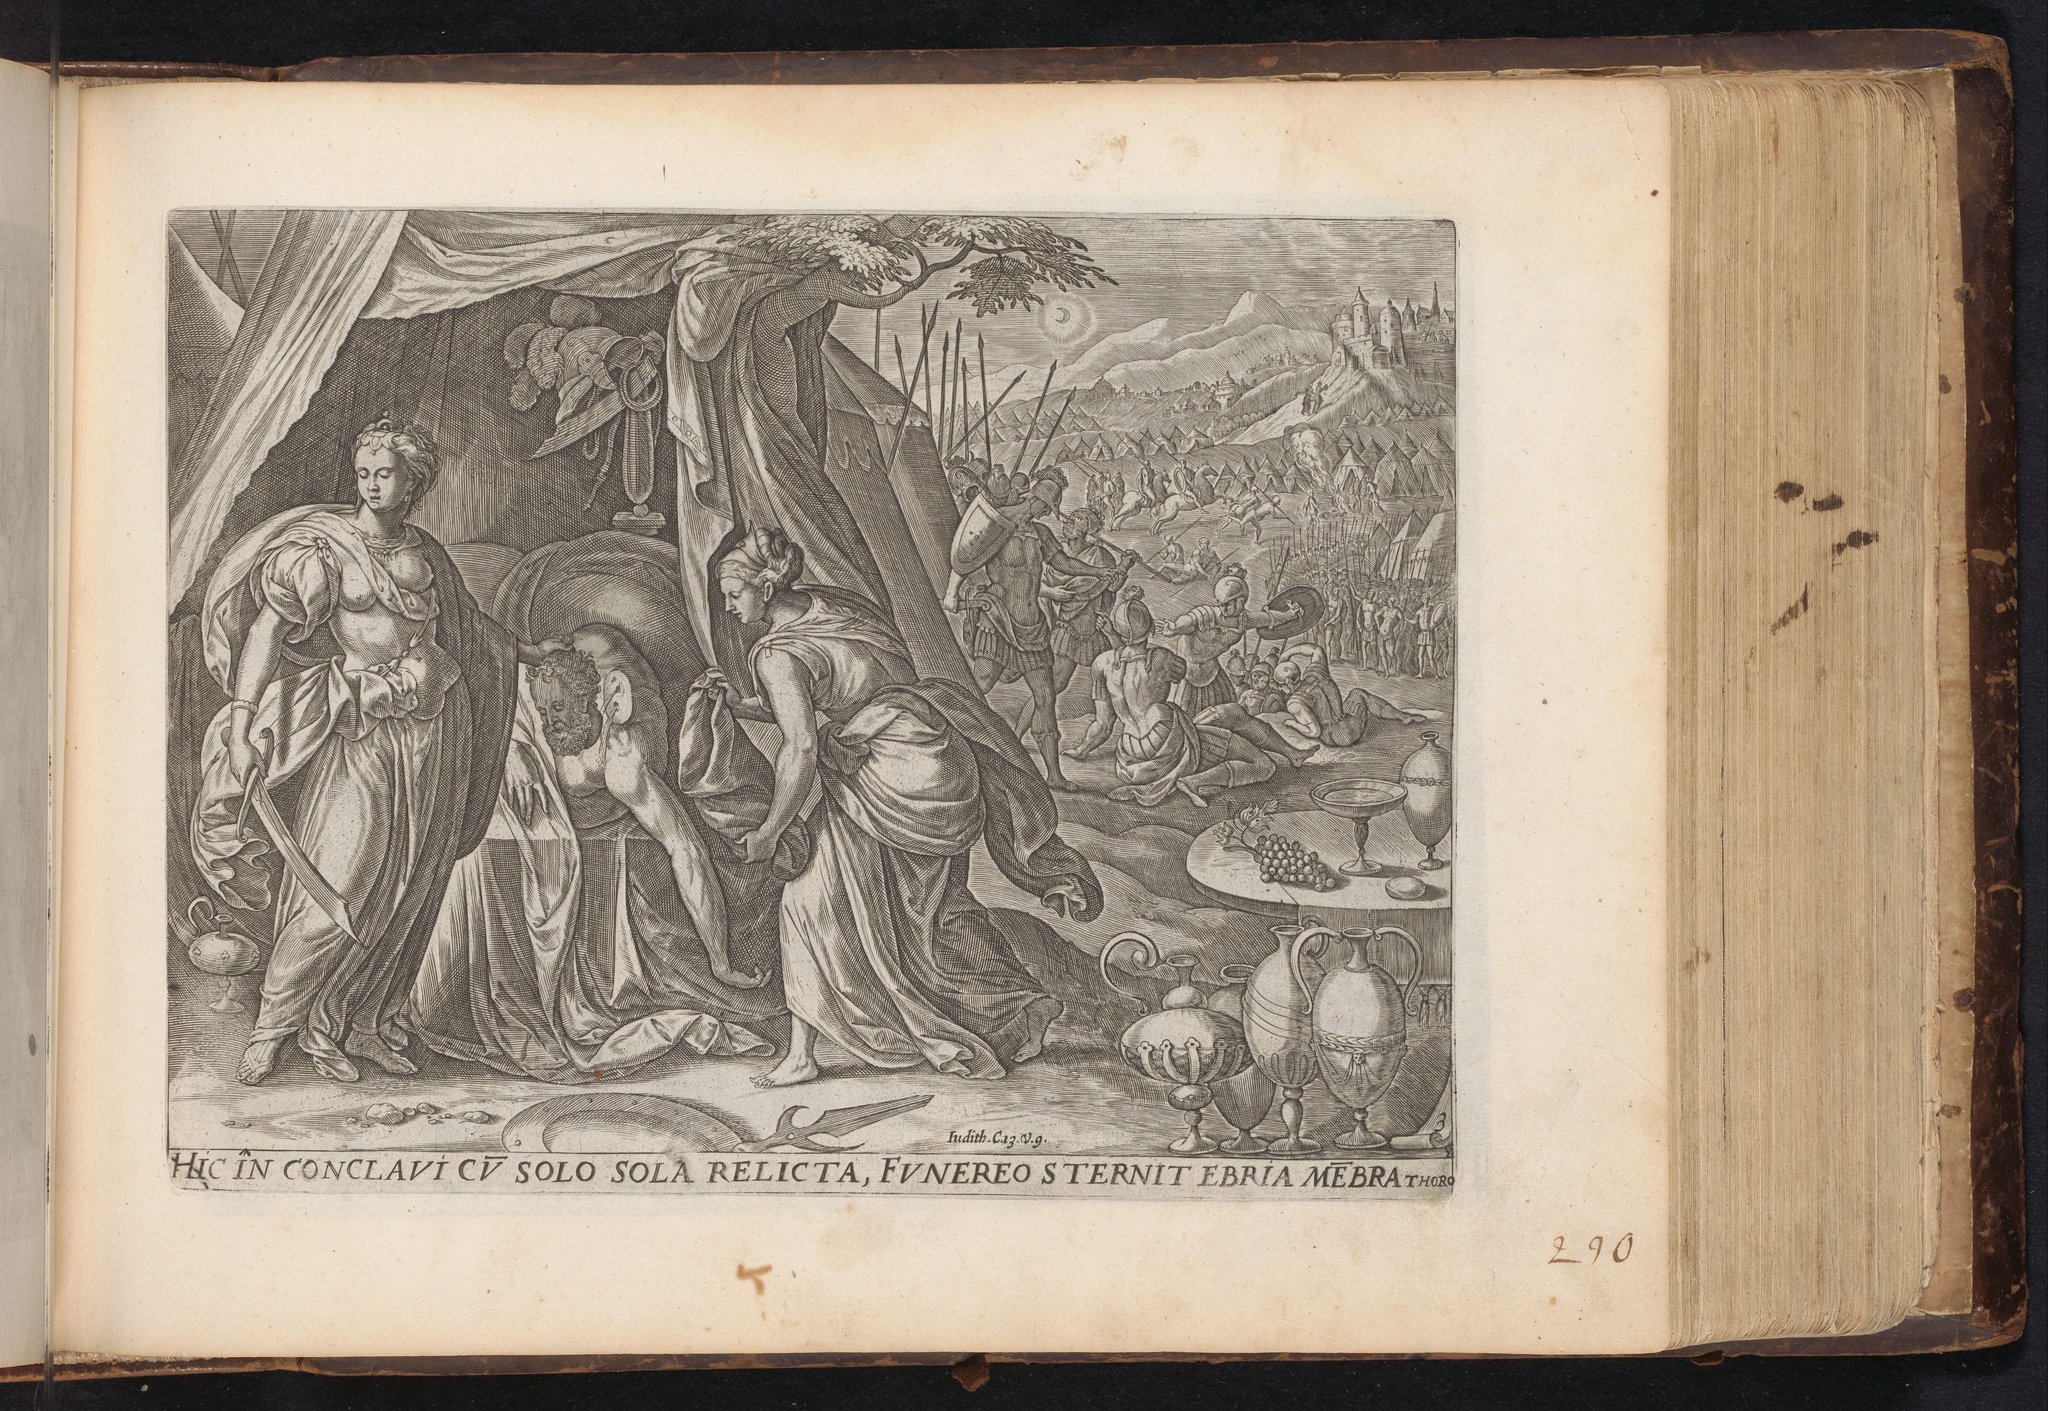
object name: print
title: Judit met het hoofd van Holofernes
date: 1579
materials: paper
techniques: engraving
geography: alkmaar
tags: judith and her maidservant put holofernes' head in a sack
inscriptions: number: ‘290’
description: Judit met het zwaard in de ene hand en het hoofd van Holofernes in de andere hand. Haar dienstmaagd houdt een zak open voor het hoofd. Achter haar de onthoofde Holofernes in zijn tent. Rechts op de achtergrond het legerkamp van de Assyriërs. Onder de voorstelling een verwijzing in het Latijn naar de Bijbeltekst in Judit 13:9. Deze prent maakt deel uit van een album.